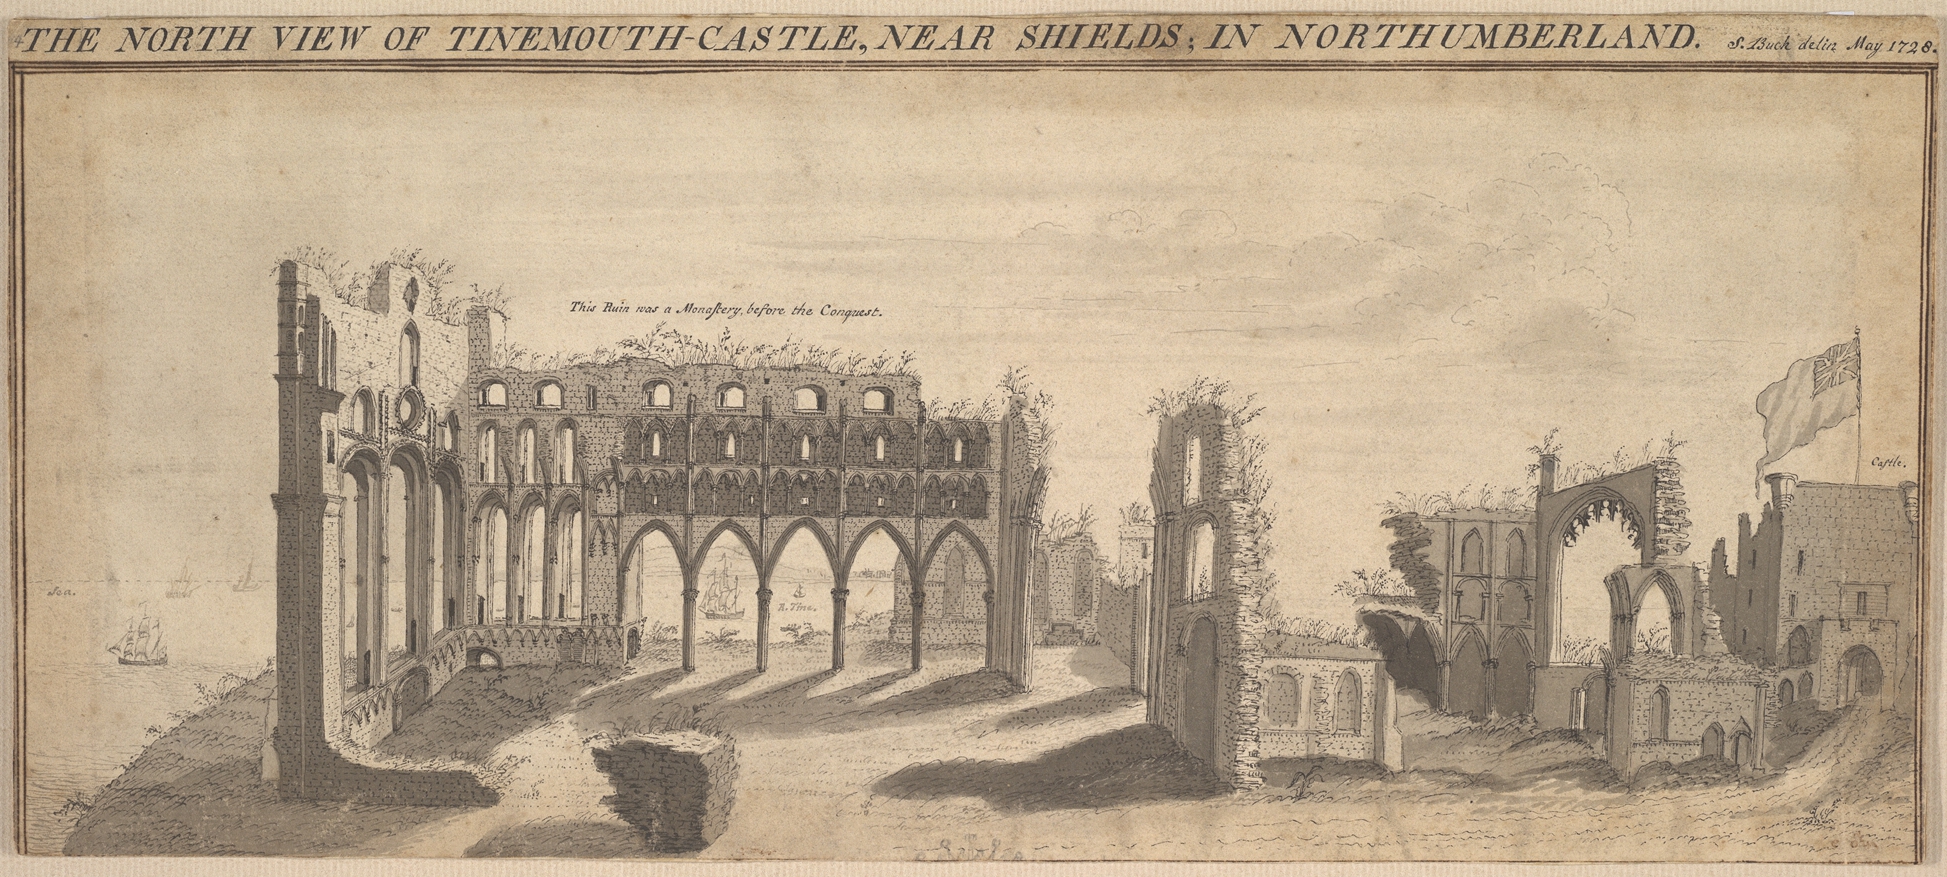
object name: drawing ornament architecture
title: Tynemouth Castle, Northumberland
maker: samuel buck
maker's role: artist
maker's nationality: british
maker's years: 1696-1779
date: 1728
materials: ink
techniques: brush, pen, wash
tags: architecture,castles,ruins,flags